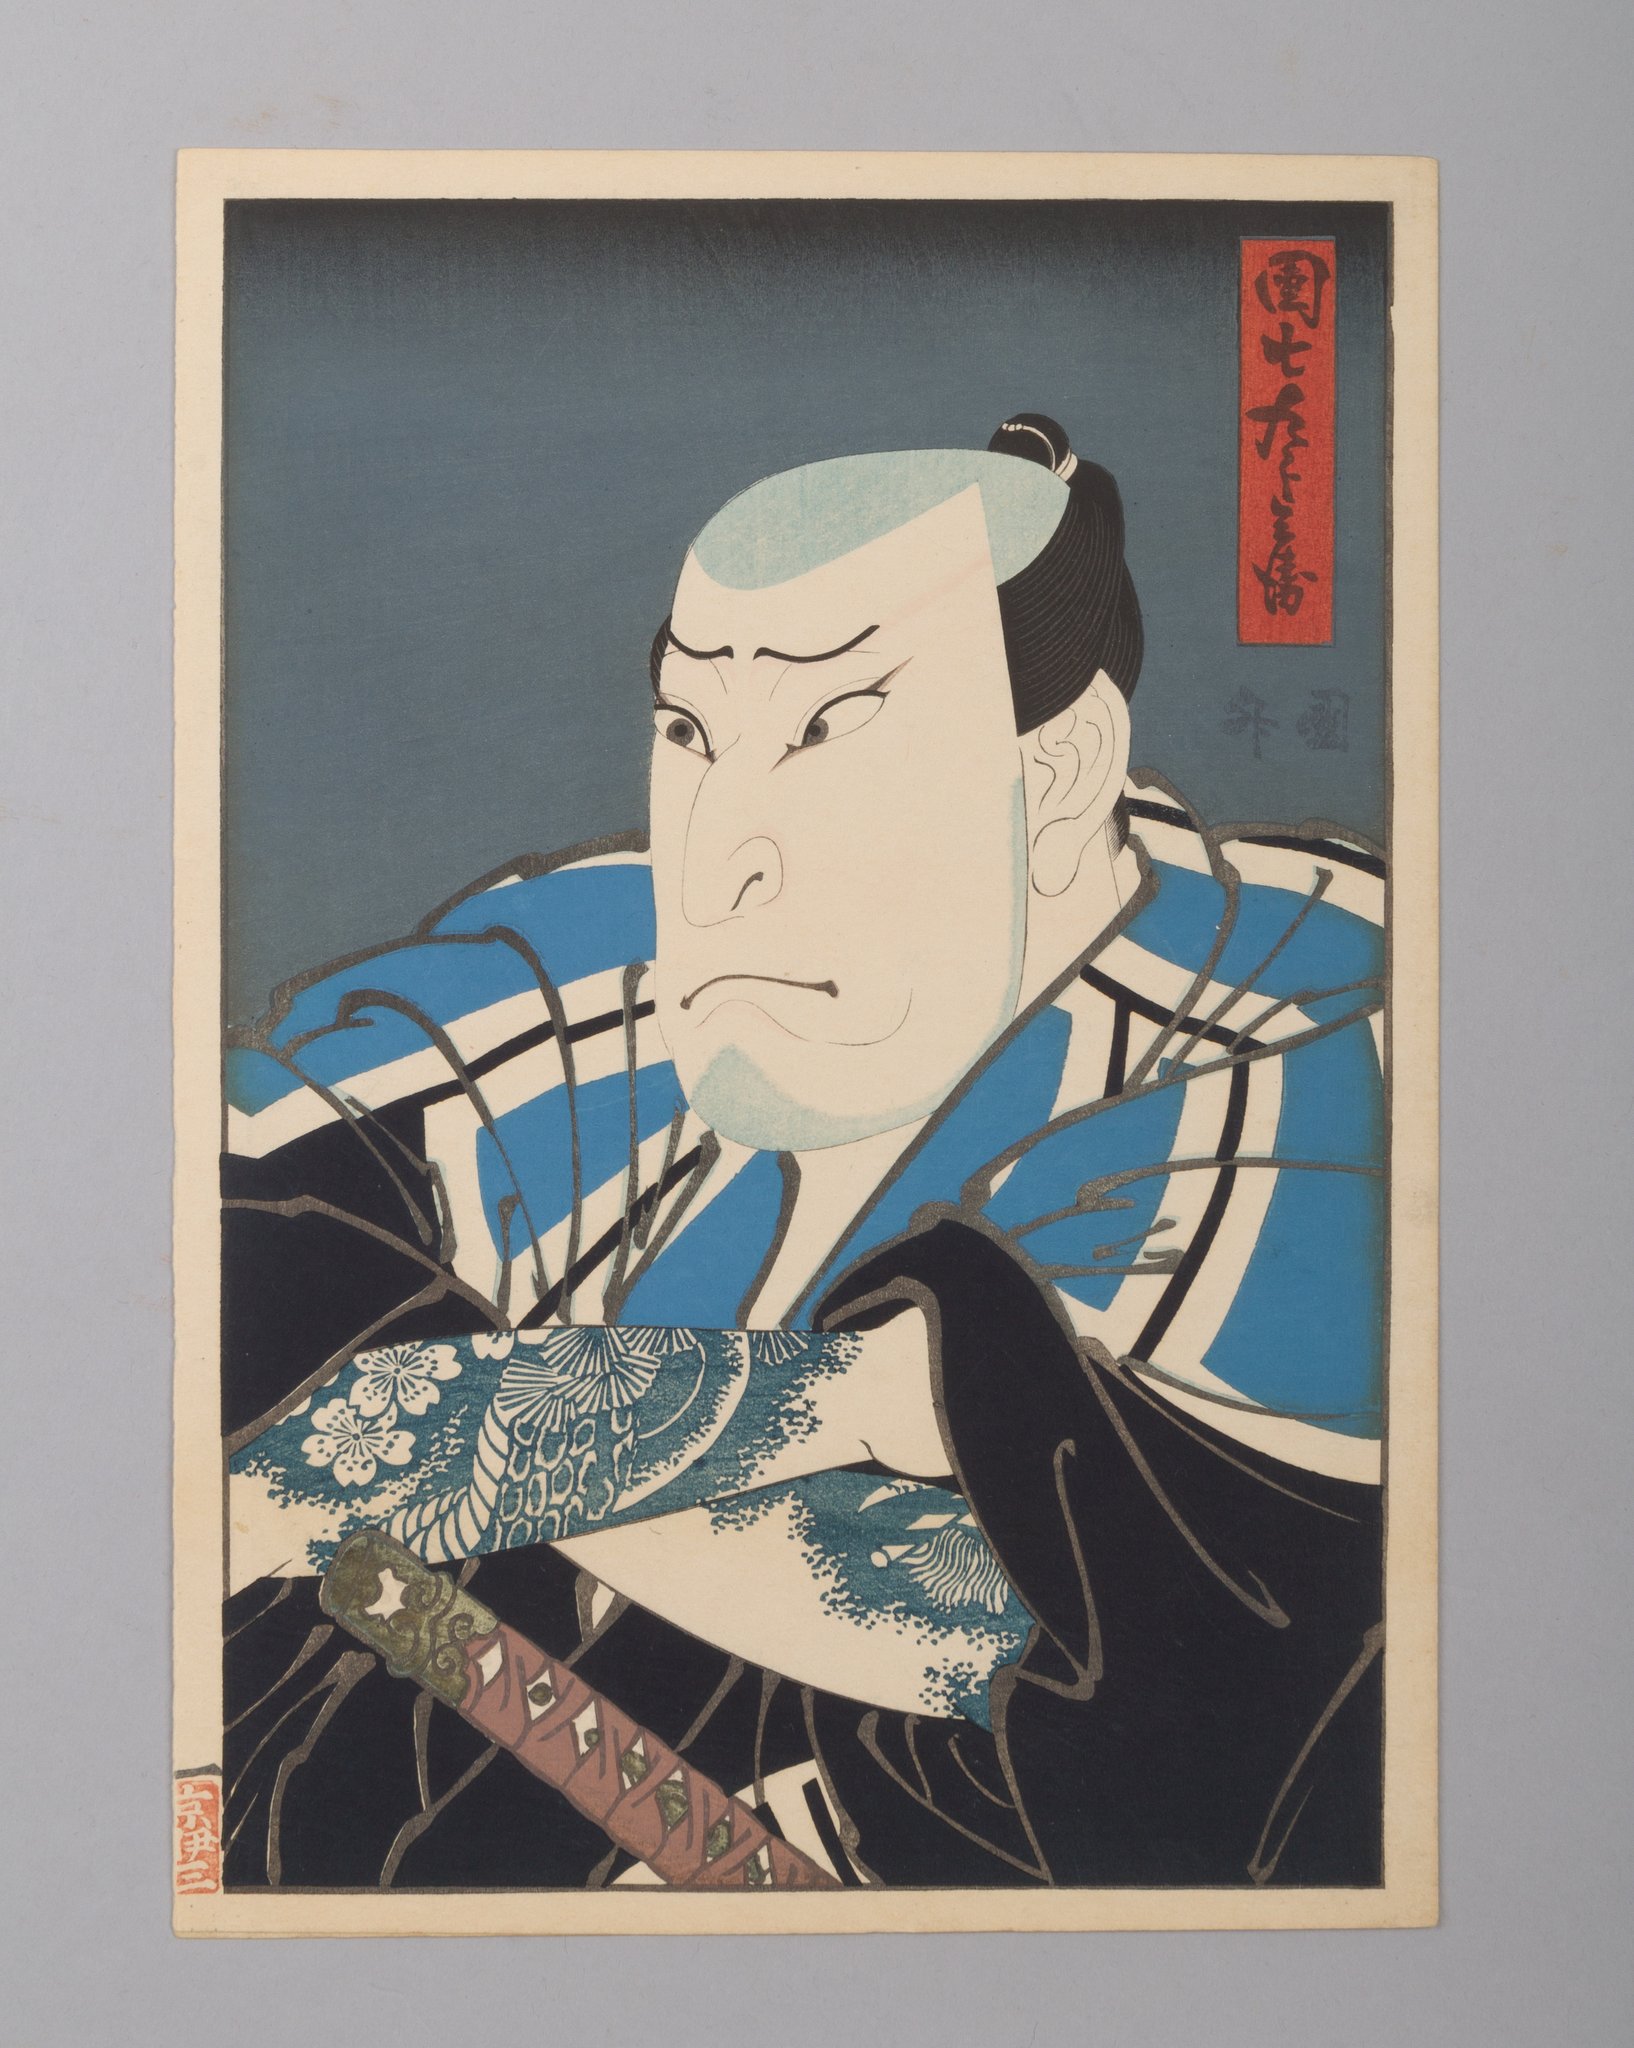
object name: woodblock print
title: Nakamura Utaemon IV as Danshichi Kurobei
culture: japanese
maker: utagawa kunimasu 歌川国升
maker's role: artist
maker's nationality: japanese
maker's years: 1830-1852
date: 1850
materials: ink, paper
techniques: nishiki e, woodblock print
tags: men,actors